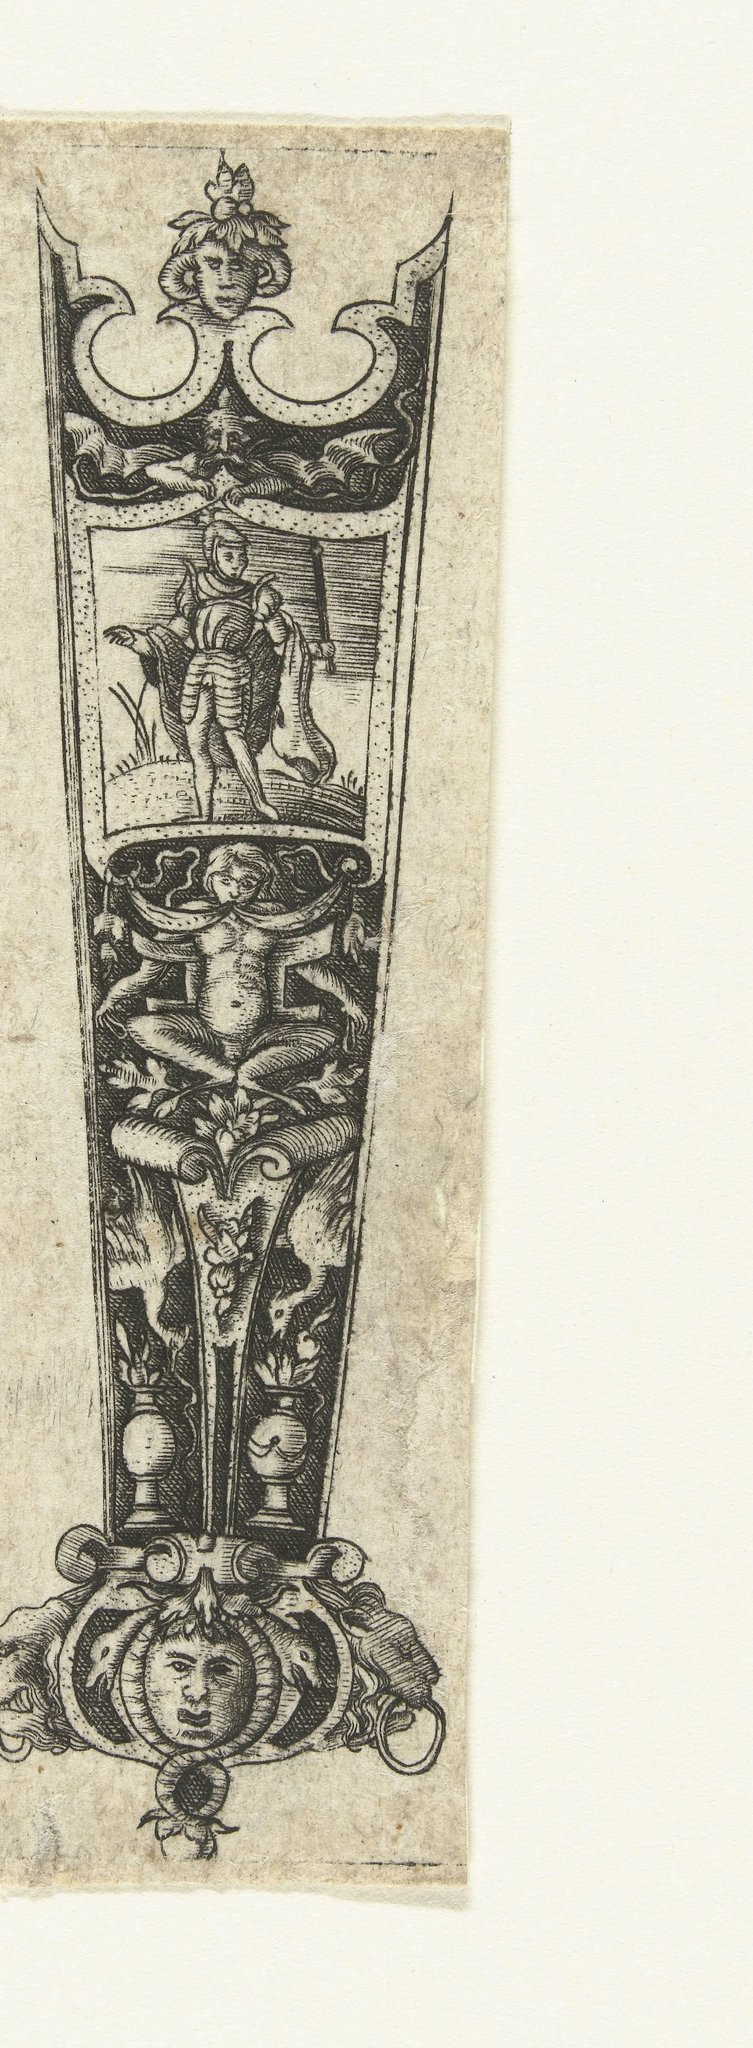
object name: print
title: Oirband met een cartouche waarin een krijgsman staat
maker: Anonymous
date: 1500-1552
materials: paper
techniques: engraving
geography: eastern europe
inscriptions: collector's mark: Lugt 240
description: Op een console van rolwerk, geflankeerd door twee vazen en twee vogels, zit een vrouwelijke sater. Daarboven staat een man in wapenrusting met een mantel om. De knop onderaan is gedecoreerd met drie mascarons, waarvan twee in de vorm van leeuwenkoppen. Uit serie, bestaande uit een titelblad en 12 bladen.